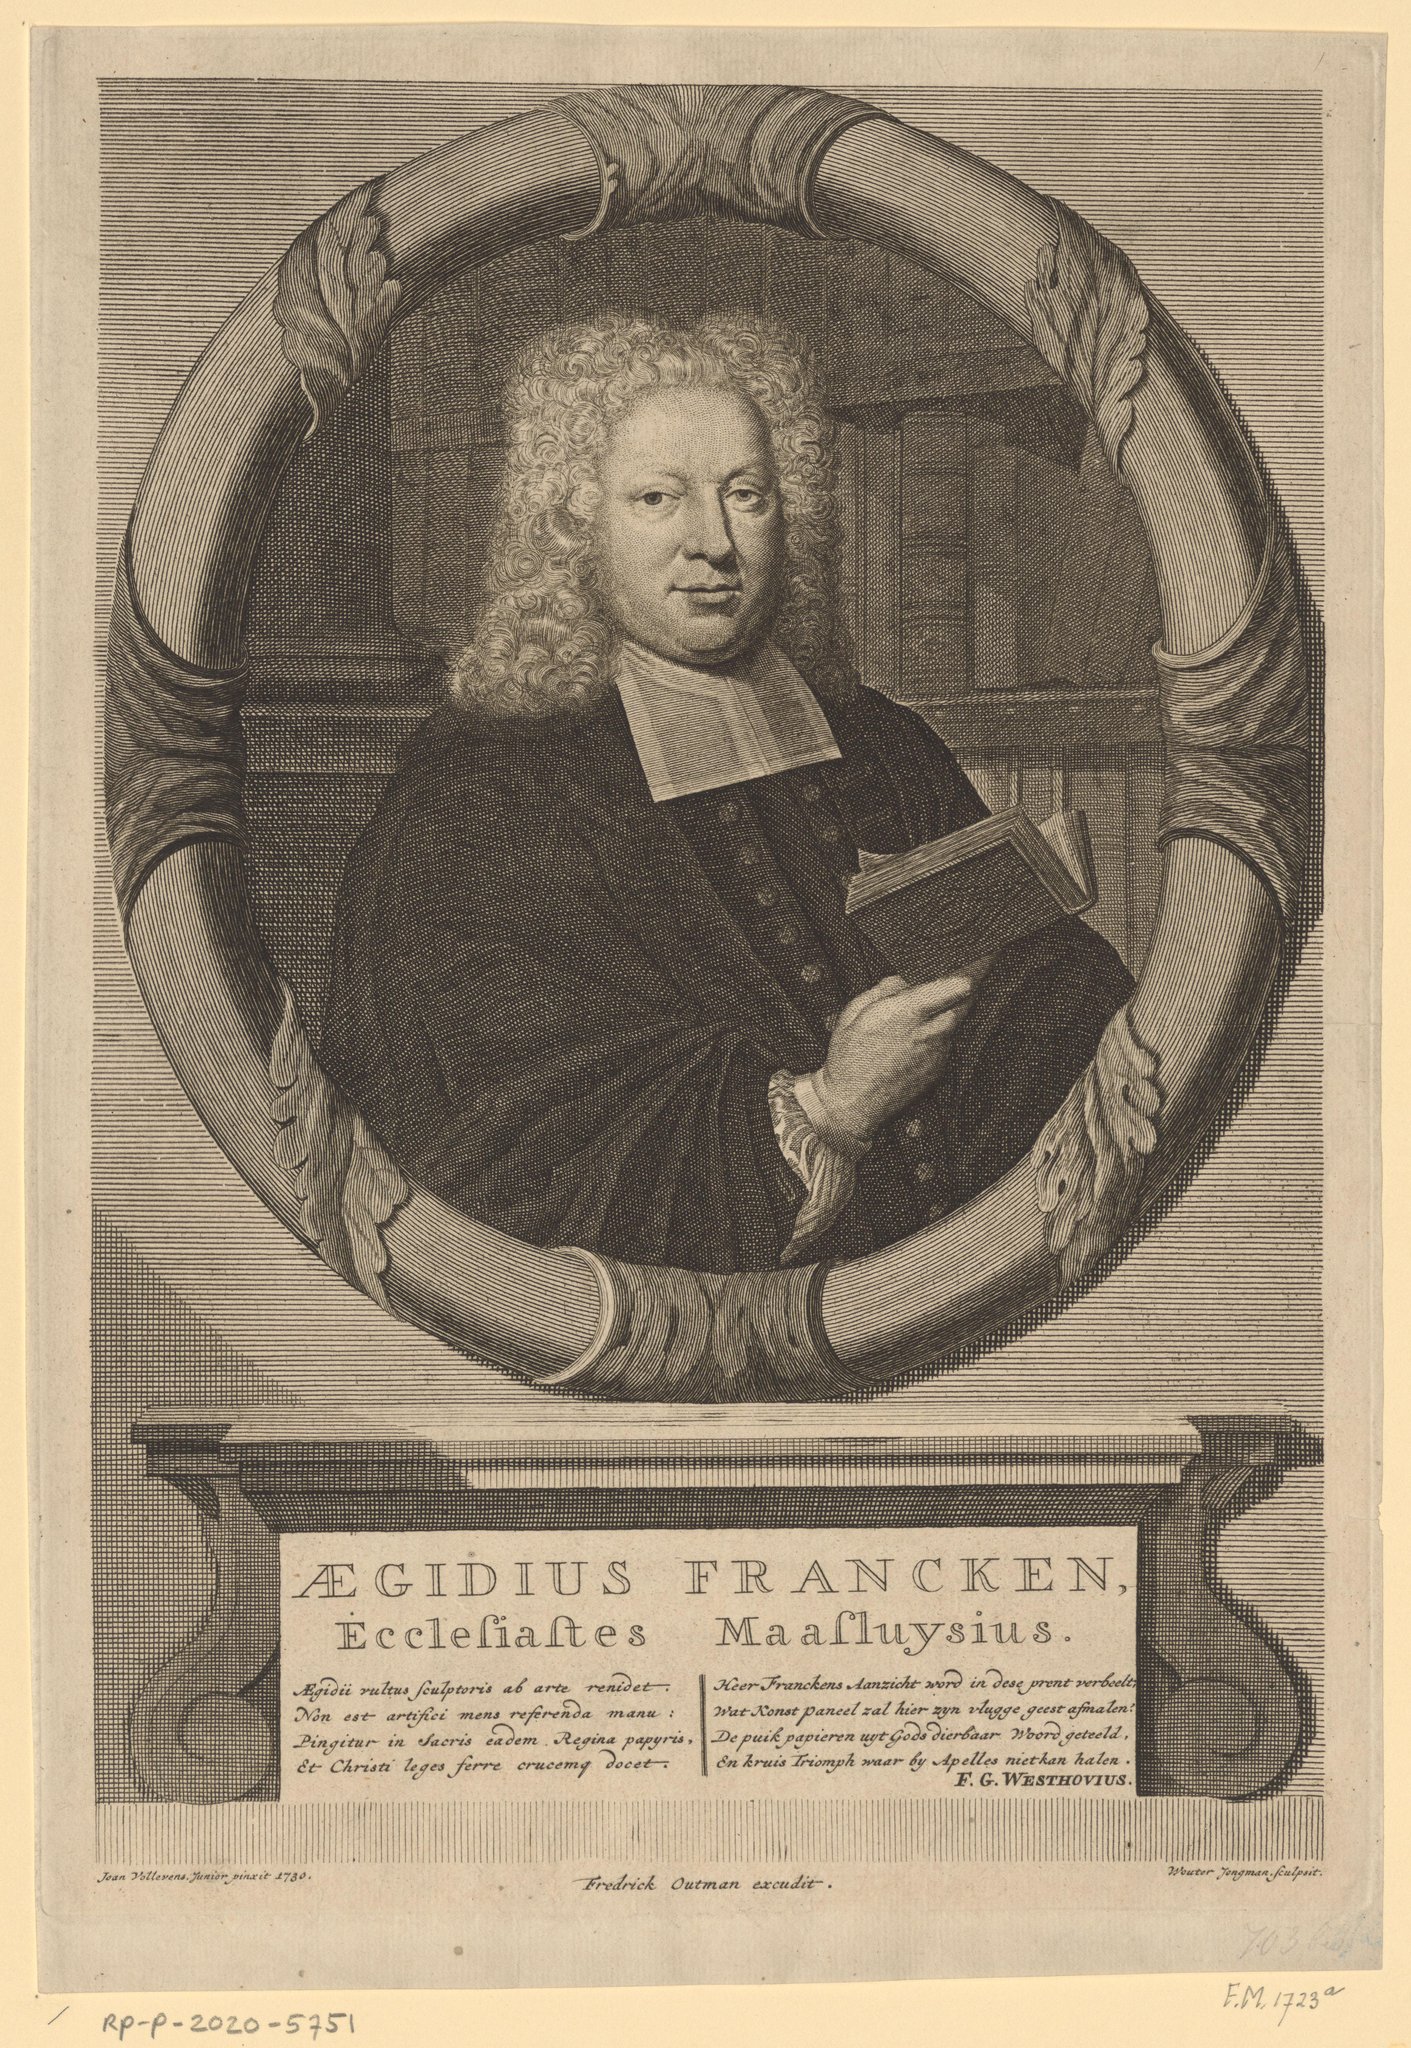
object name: print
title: Portret van Aegidius Francken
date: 1730-1744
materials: paper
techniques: engraving, etching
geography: amsterdam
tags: bookshelves, theologian, historical persons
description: Met vierregelig vers in het Latijn en Nederlands onder het portret.